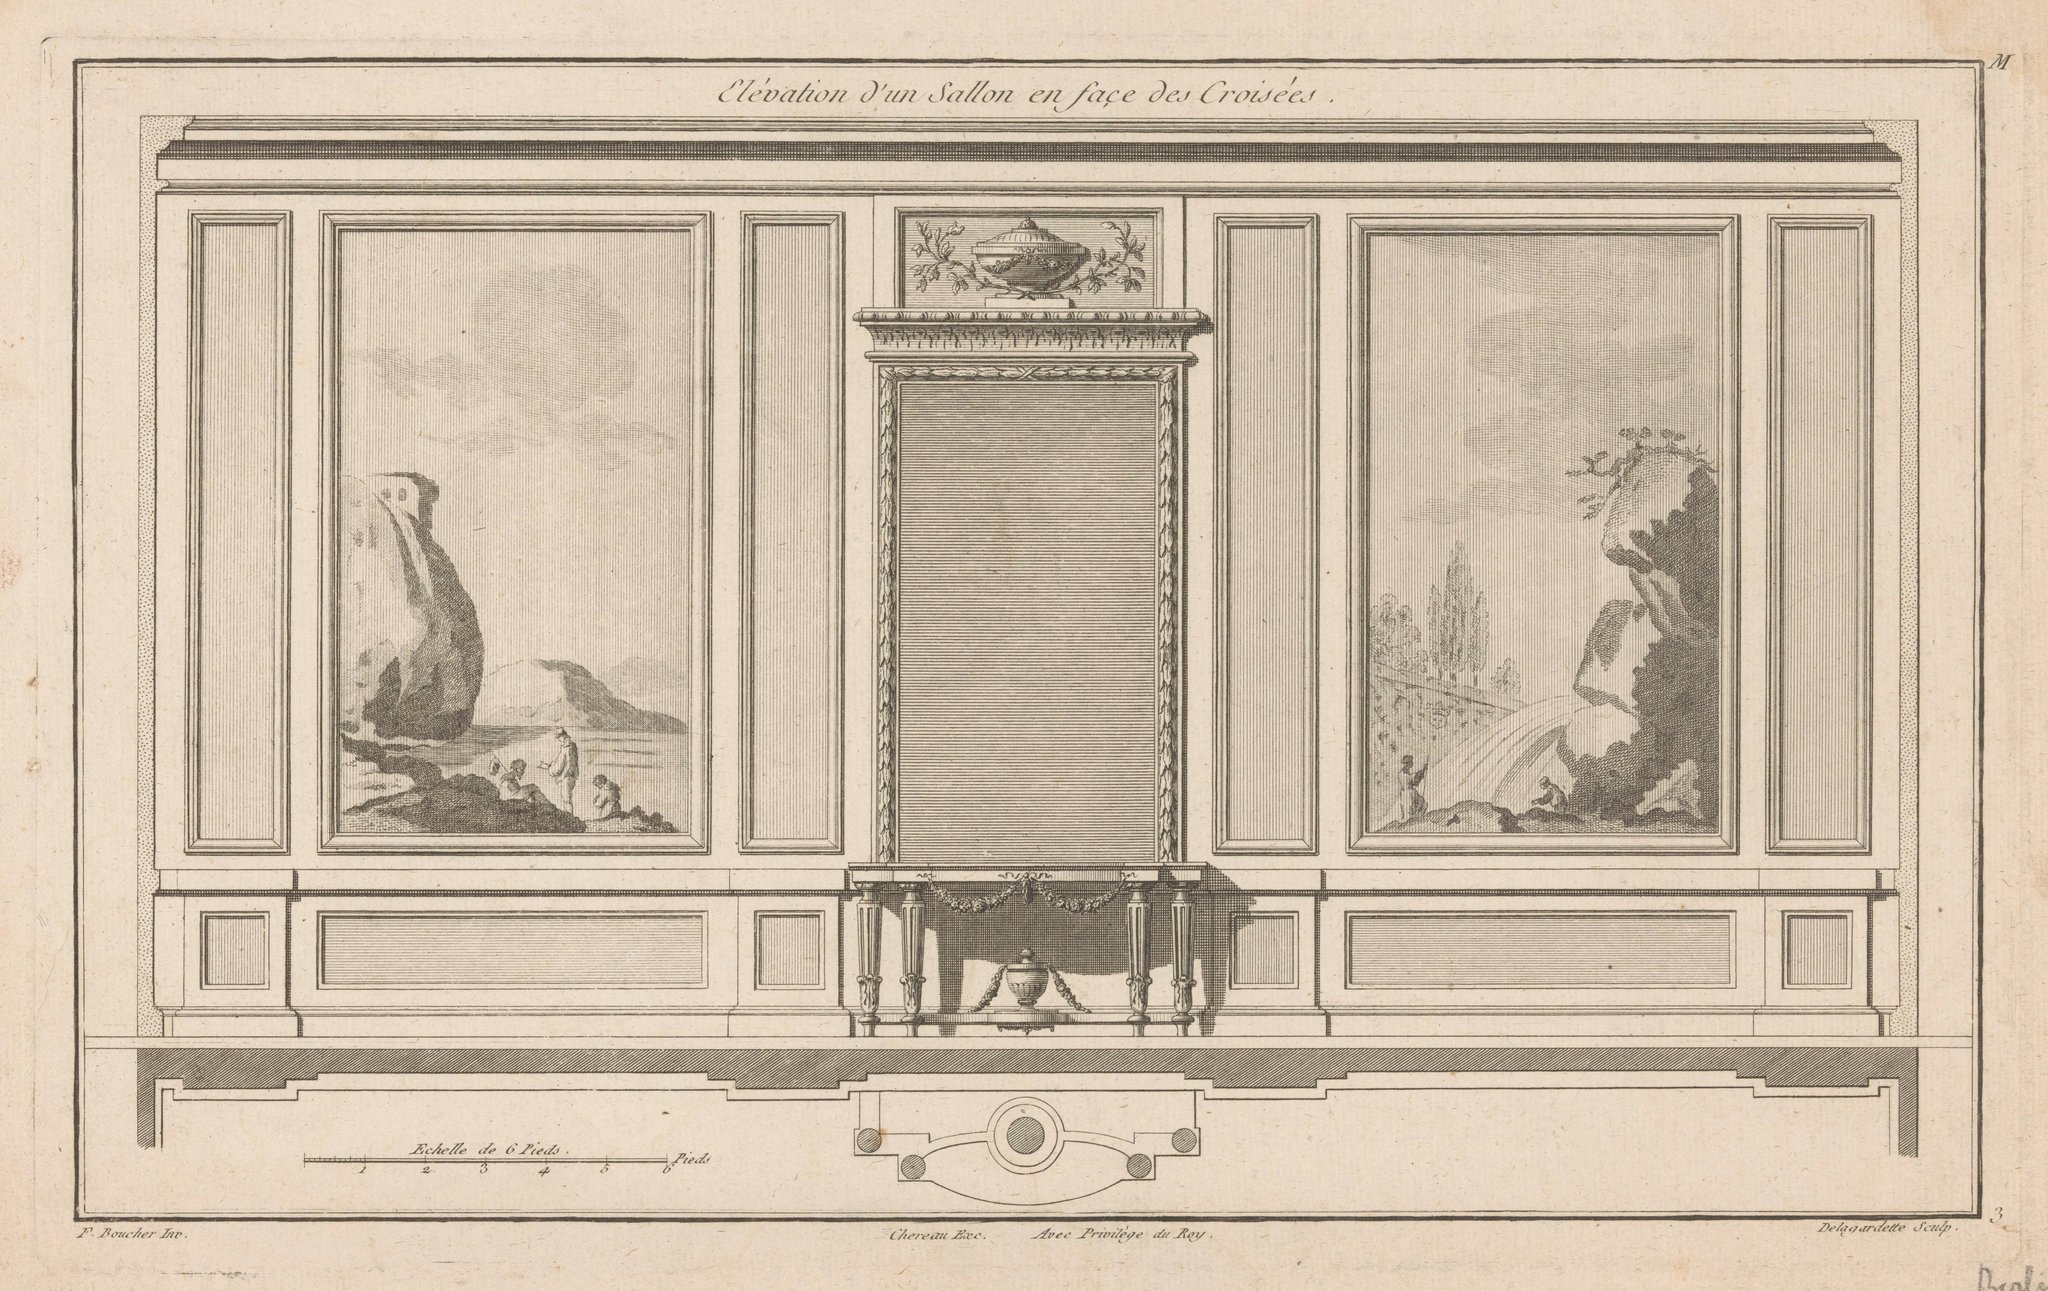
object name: print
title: Salon met tafel en panelen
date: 1753-1782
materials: paper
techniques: engraving, etching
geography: paris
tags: panelling, table, communal rooms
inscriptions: collector's mark: Lugt 2228, collector's mark: Lugt 2760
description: Ontwerp en plattegrond van een salon met twee panelen met figuren in waterlandschappen, in het midden staat een geornamenteerde tafel.